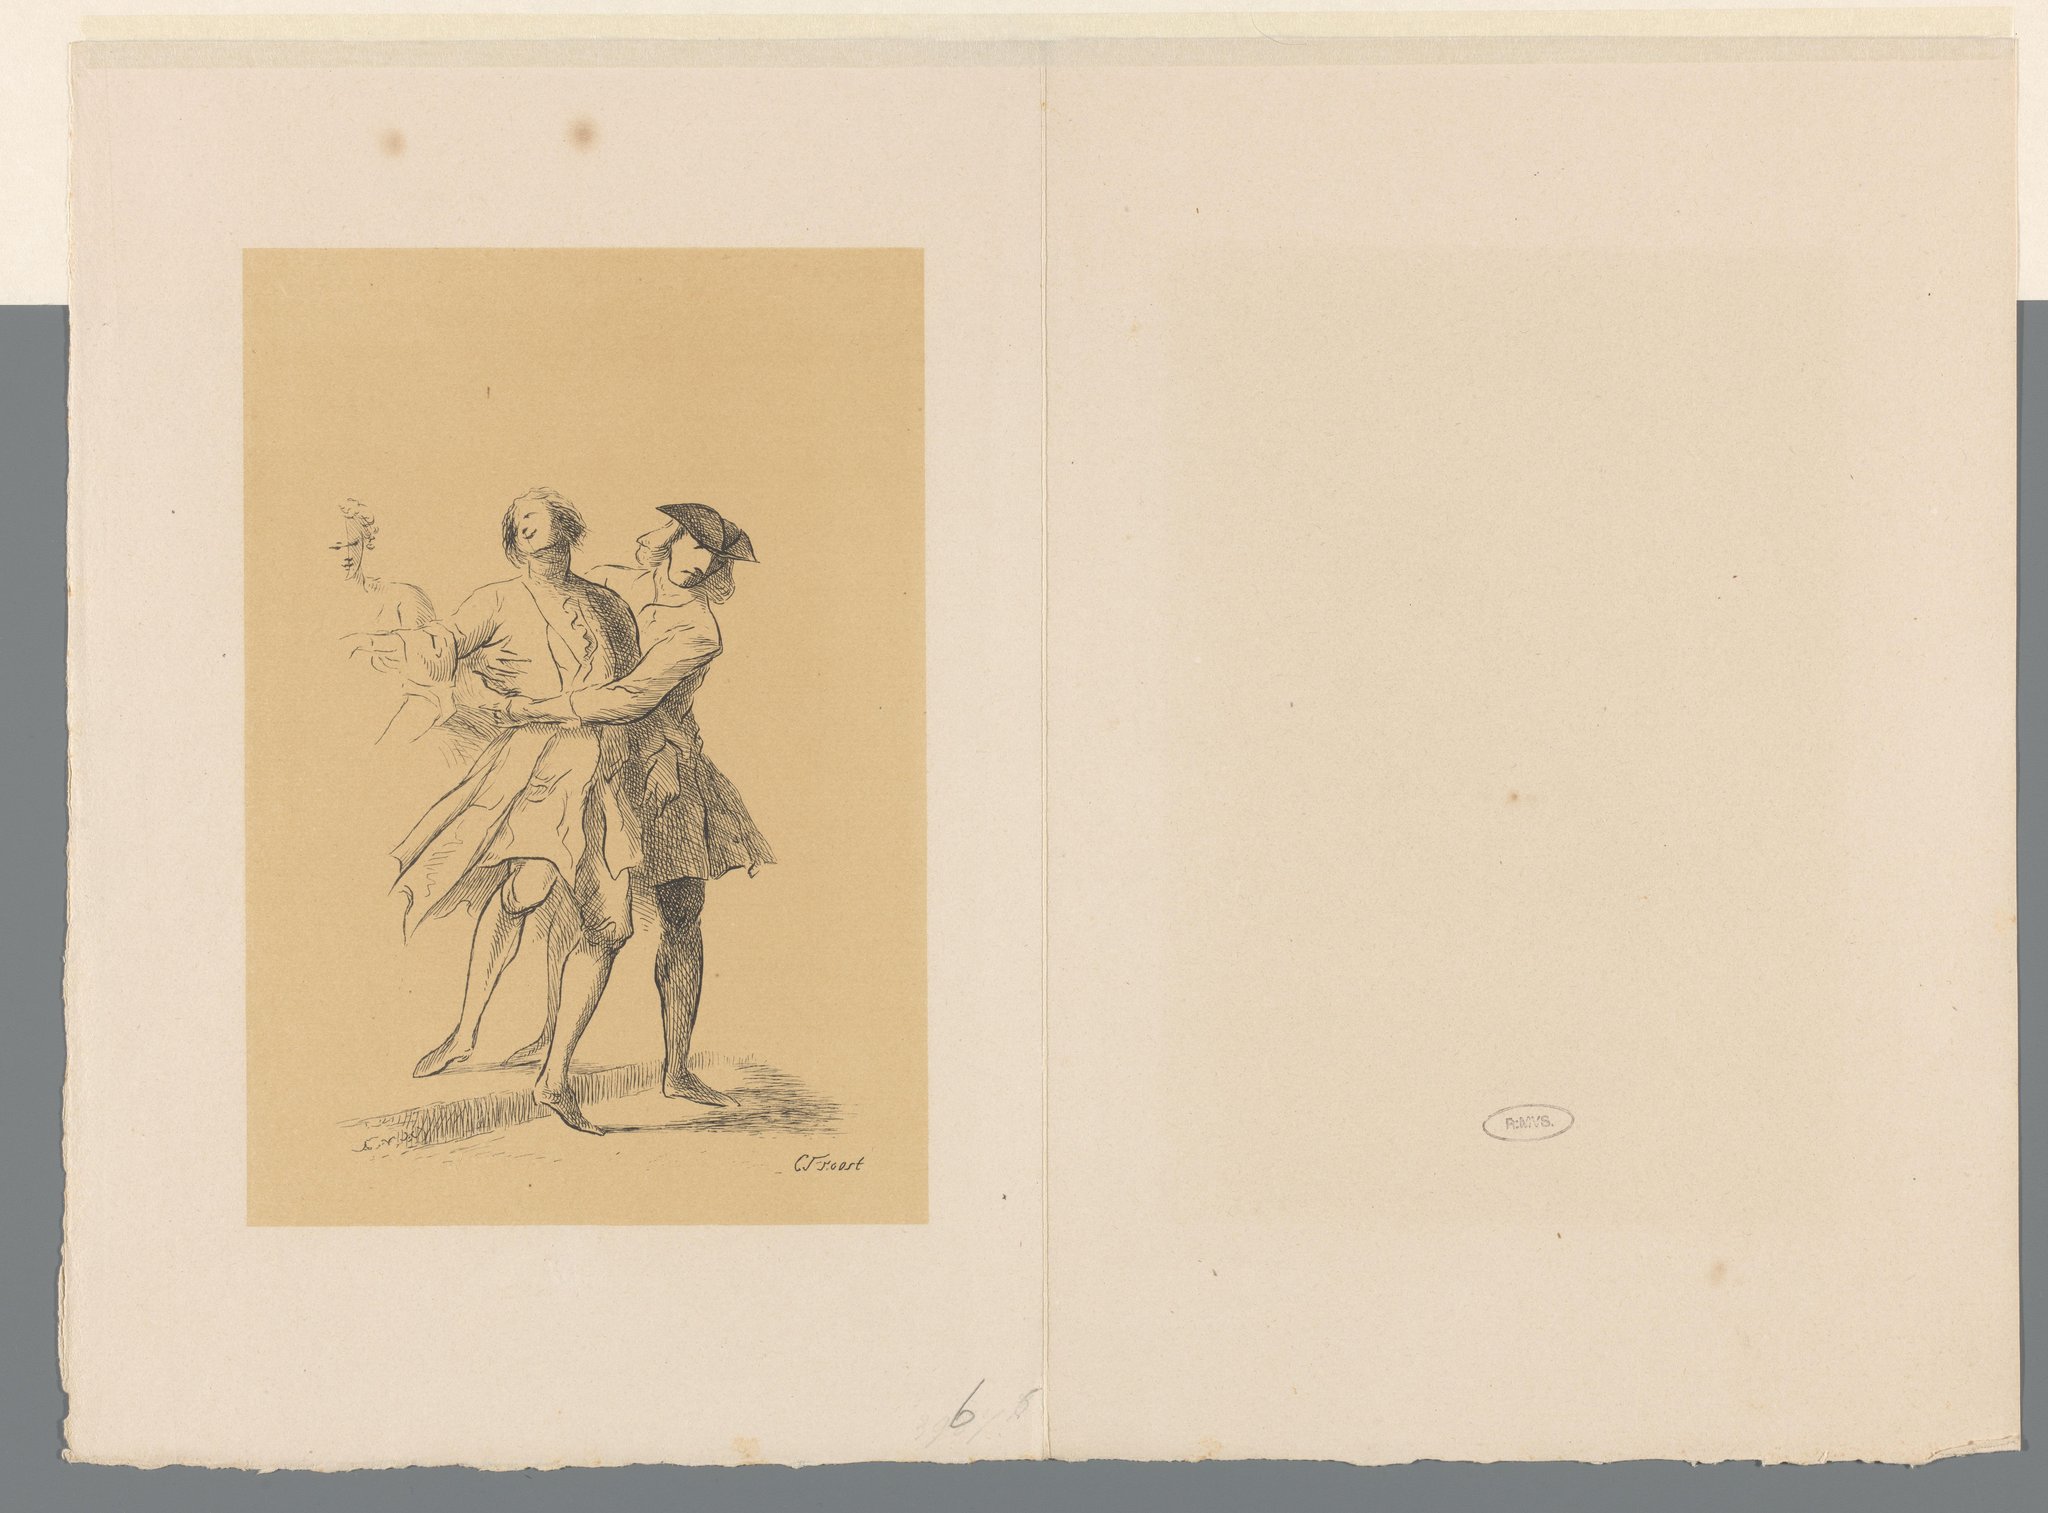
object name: book illustration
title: Man ondersteund jongeman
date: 1873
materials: paper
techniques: tone lithography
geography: arnhem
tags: adult man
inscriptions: collector's mark: Lugt 2228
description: Prent uit: Ver Huell, Alexander. Cornelist troost en zijn werken. Arnhem: Gouda Quint, Paulus, 1873.